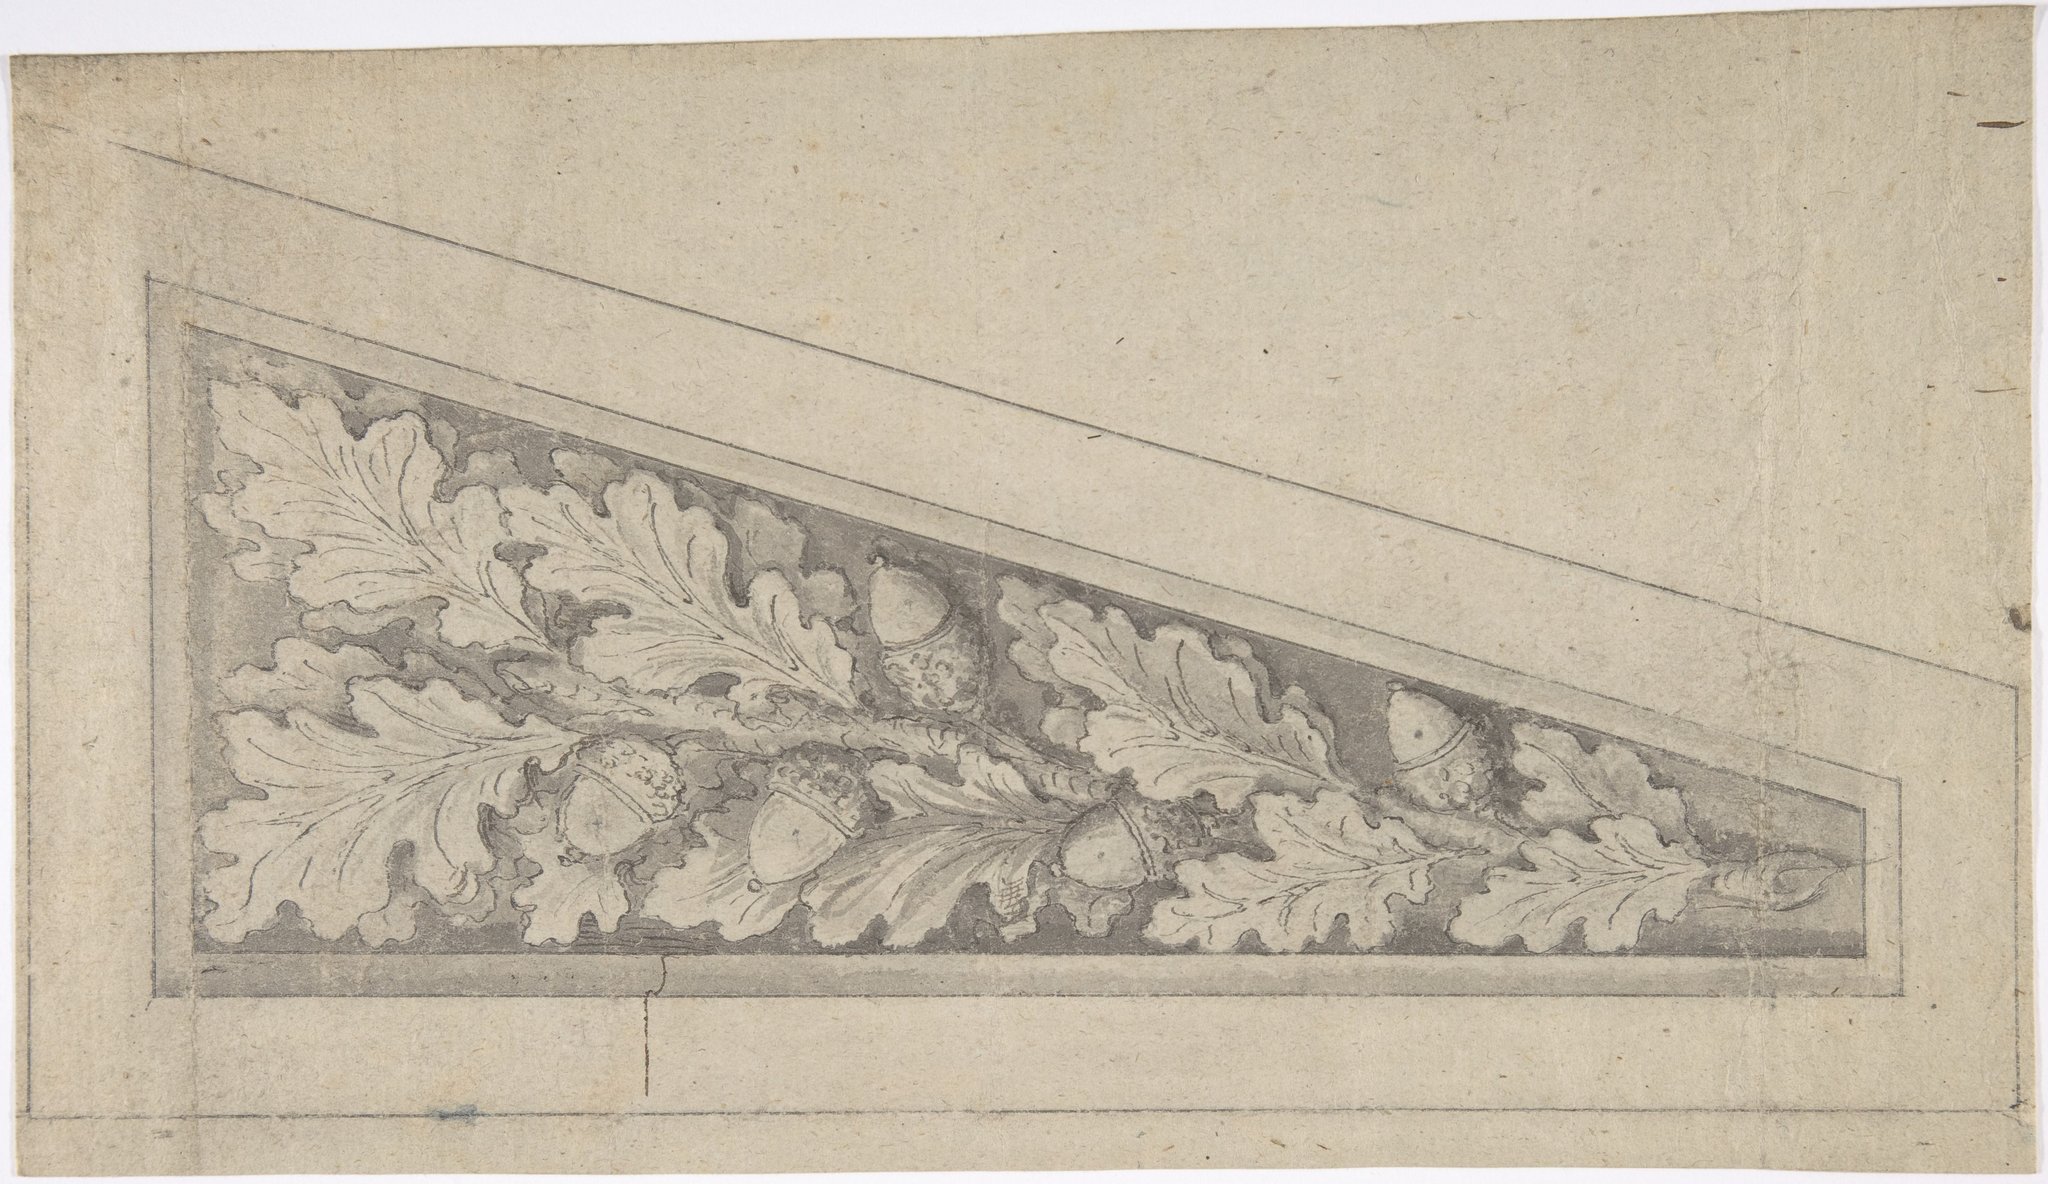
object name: drawing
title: Ornamental Panel with Oak Leaves and Acorns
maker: anonymous, british, 18th century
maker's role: artist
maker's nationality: british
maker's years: 1700-1800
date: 1701-1800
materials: ink, paper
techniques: brush, pen, wash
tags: acorns,leaves,oaks